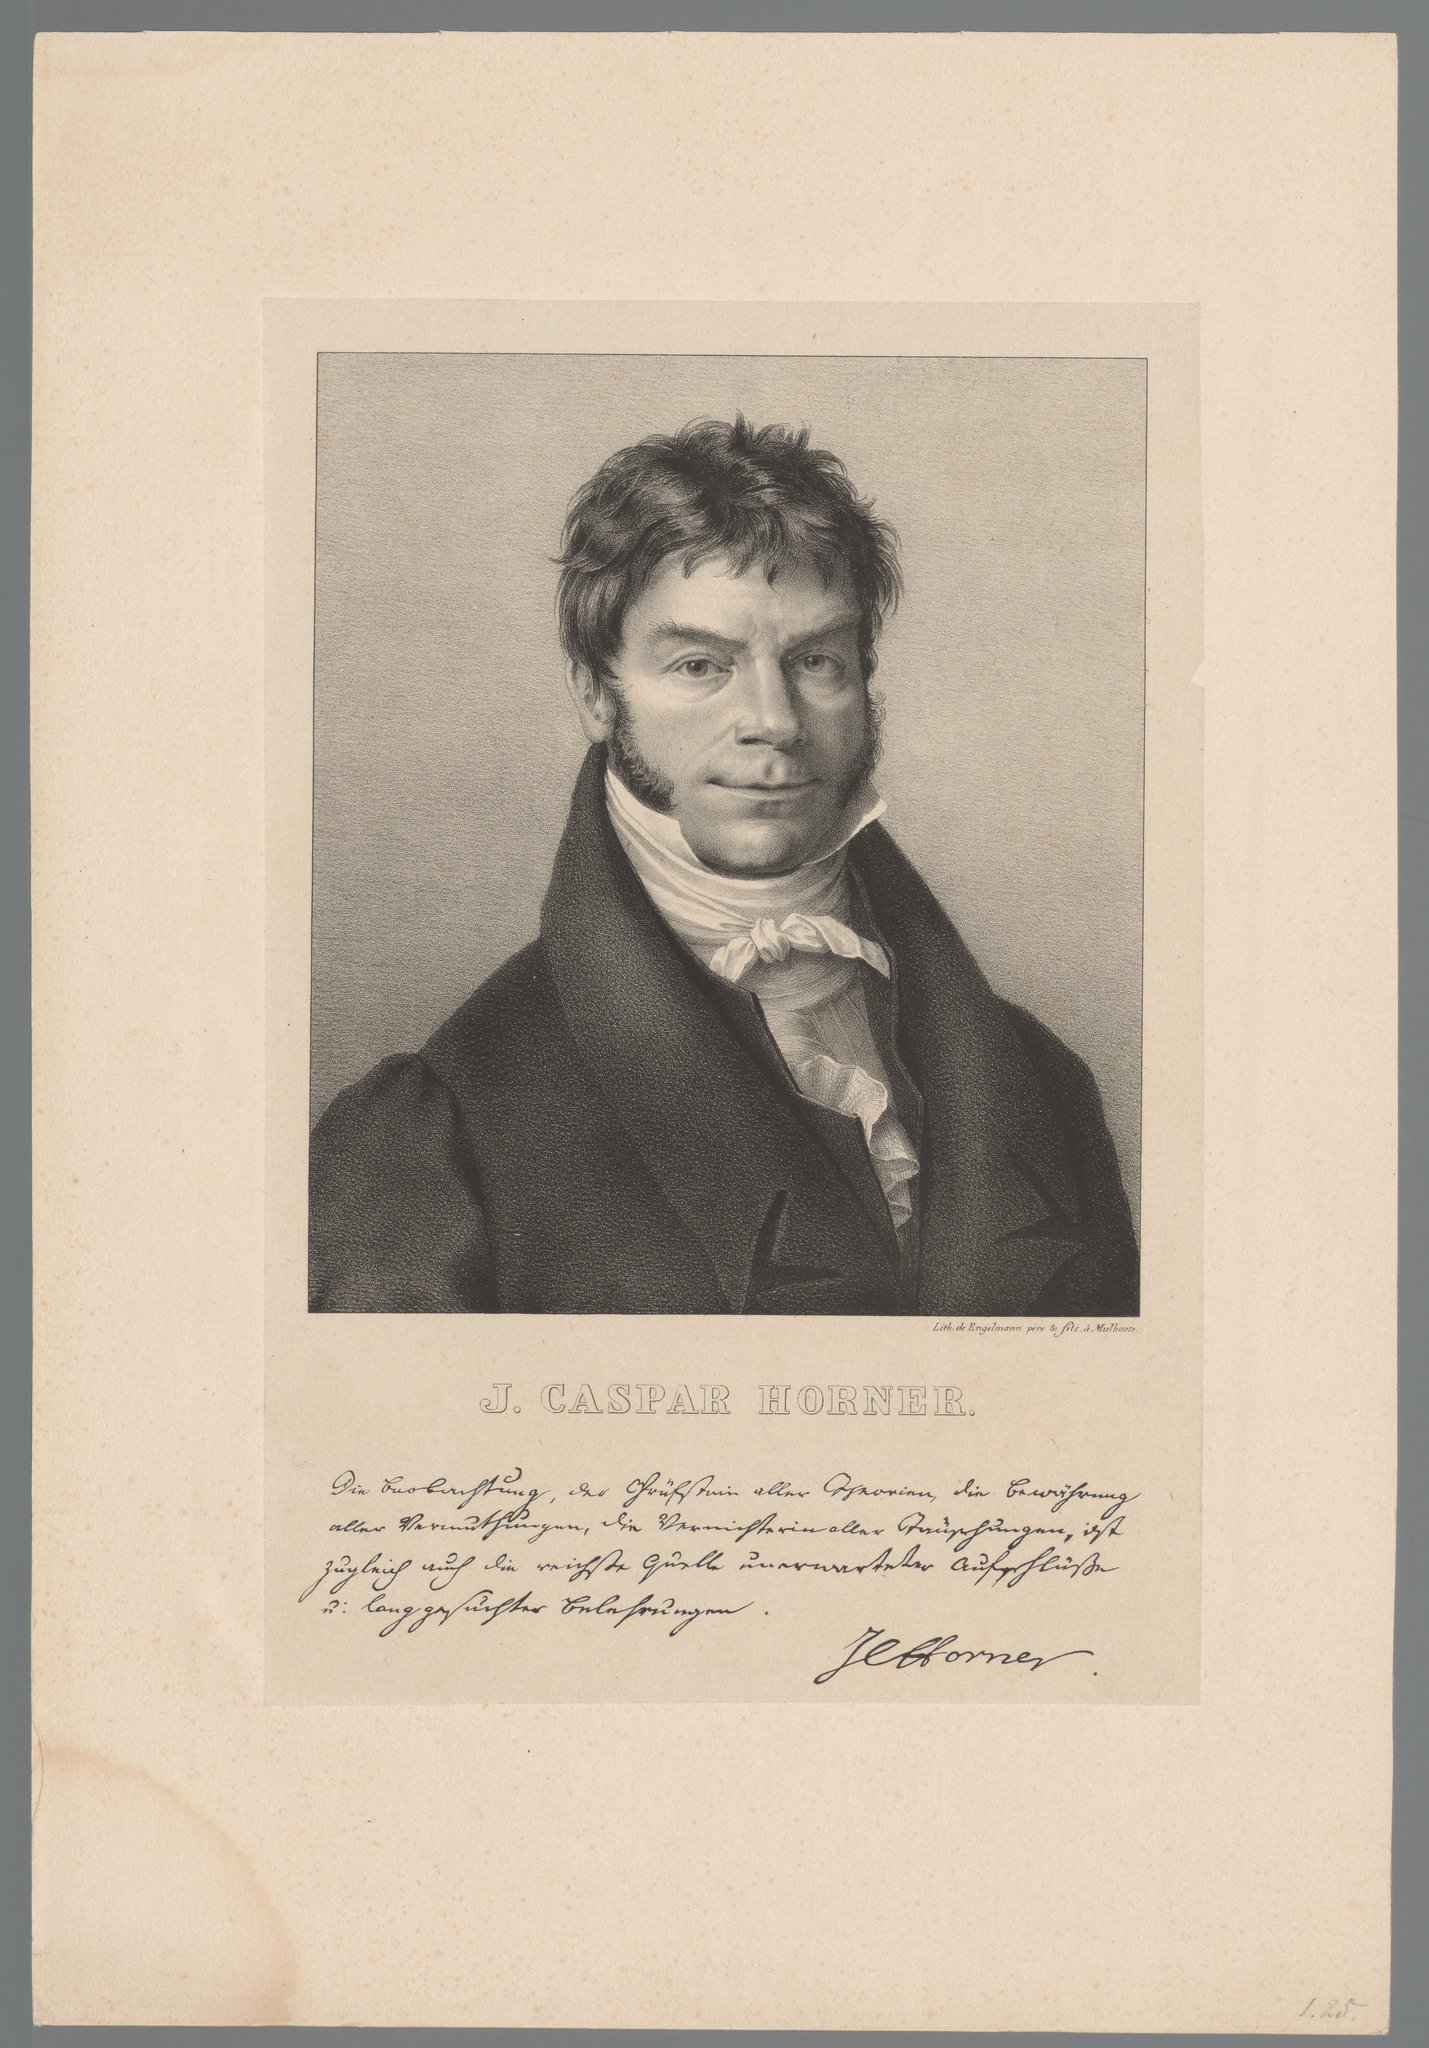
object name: print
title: Portret van Johann Kaspar Horner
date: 1833-1880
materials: paper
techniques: lithograph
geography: mulhouse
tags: adult man, historical persons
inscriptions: collector's mark: Lugt 2228